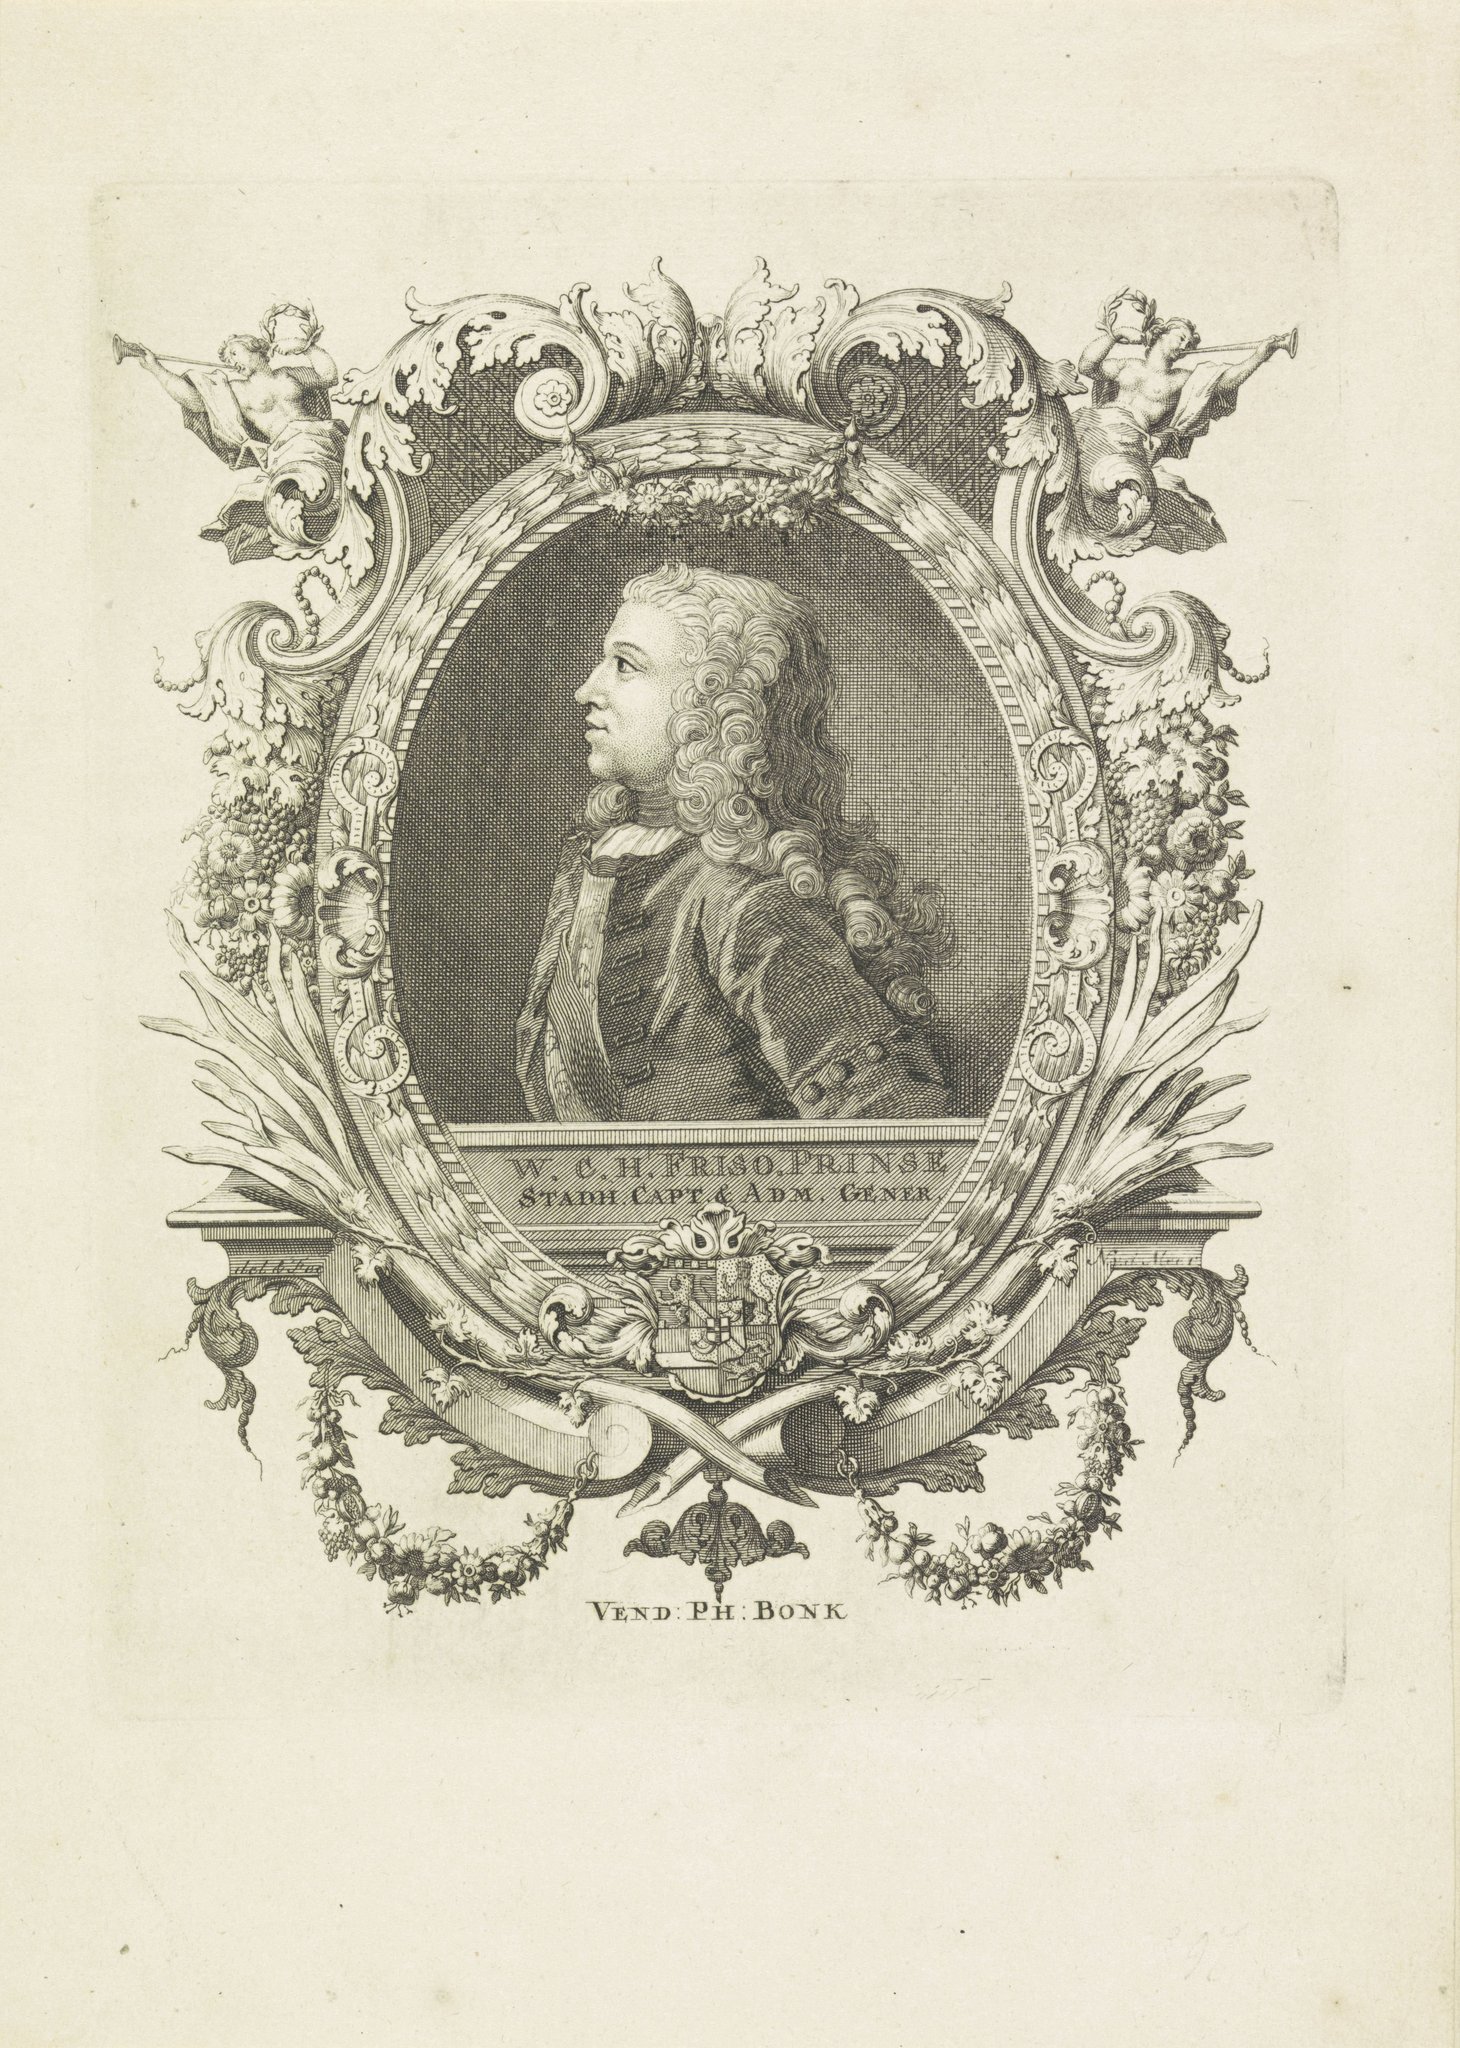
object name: print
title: Portret van Willem IV, prins van Oranje-Nassau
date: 1738-1751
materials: paper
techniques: engraving, etching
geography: leiden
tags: the hague, willem iv (prins van oranje-nassau)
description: De hier vermelde titel verwijst naar de hoogst verkregen titel van de geportretteerde, niet per se naar de titel die de geportretteerde op deze voorstelling draagt.